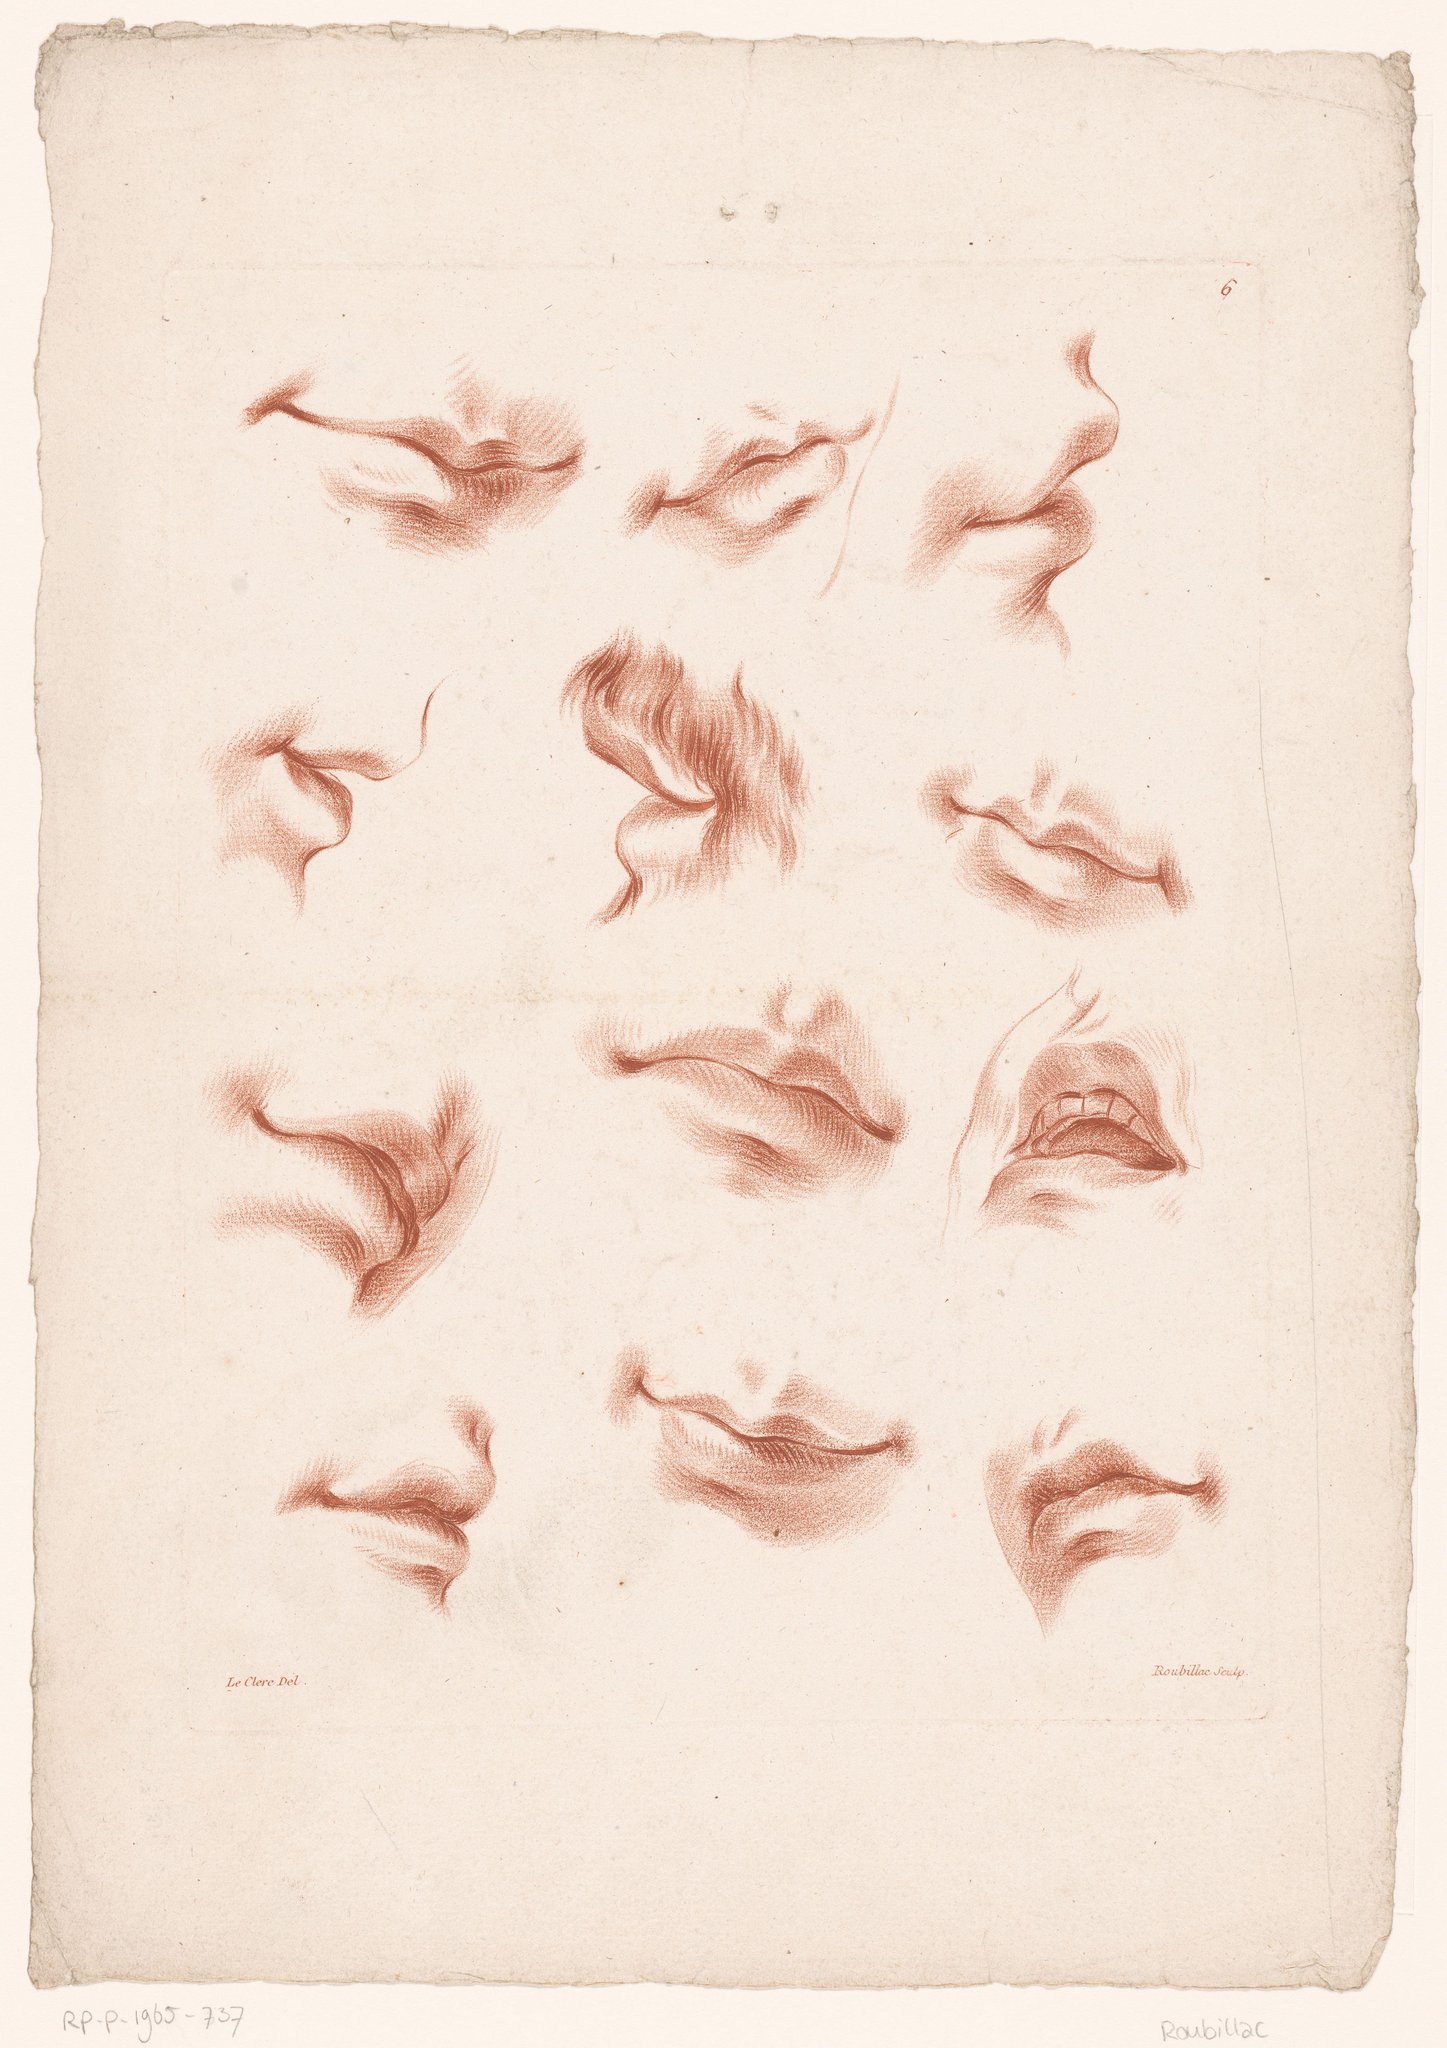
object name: print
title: Principes van het tekenen naar de natuur, deel één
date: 1784-1796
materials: paper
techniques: printmaking, etching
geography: paris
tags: drawing, sketch, mouth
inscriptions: collector's mark: Lugt 2228